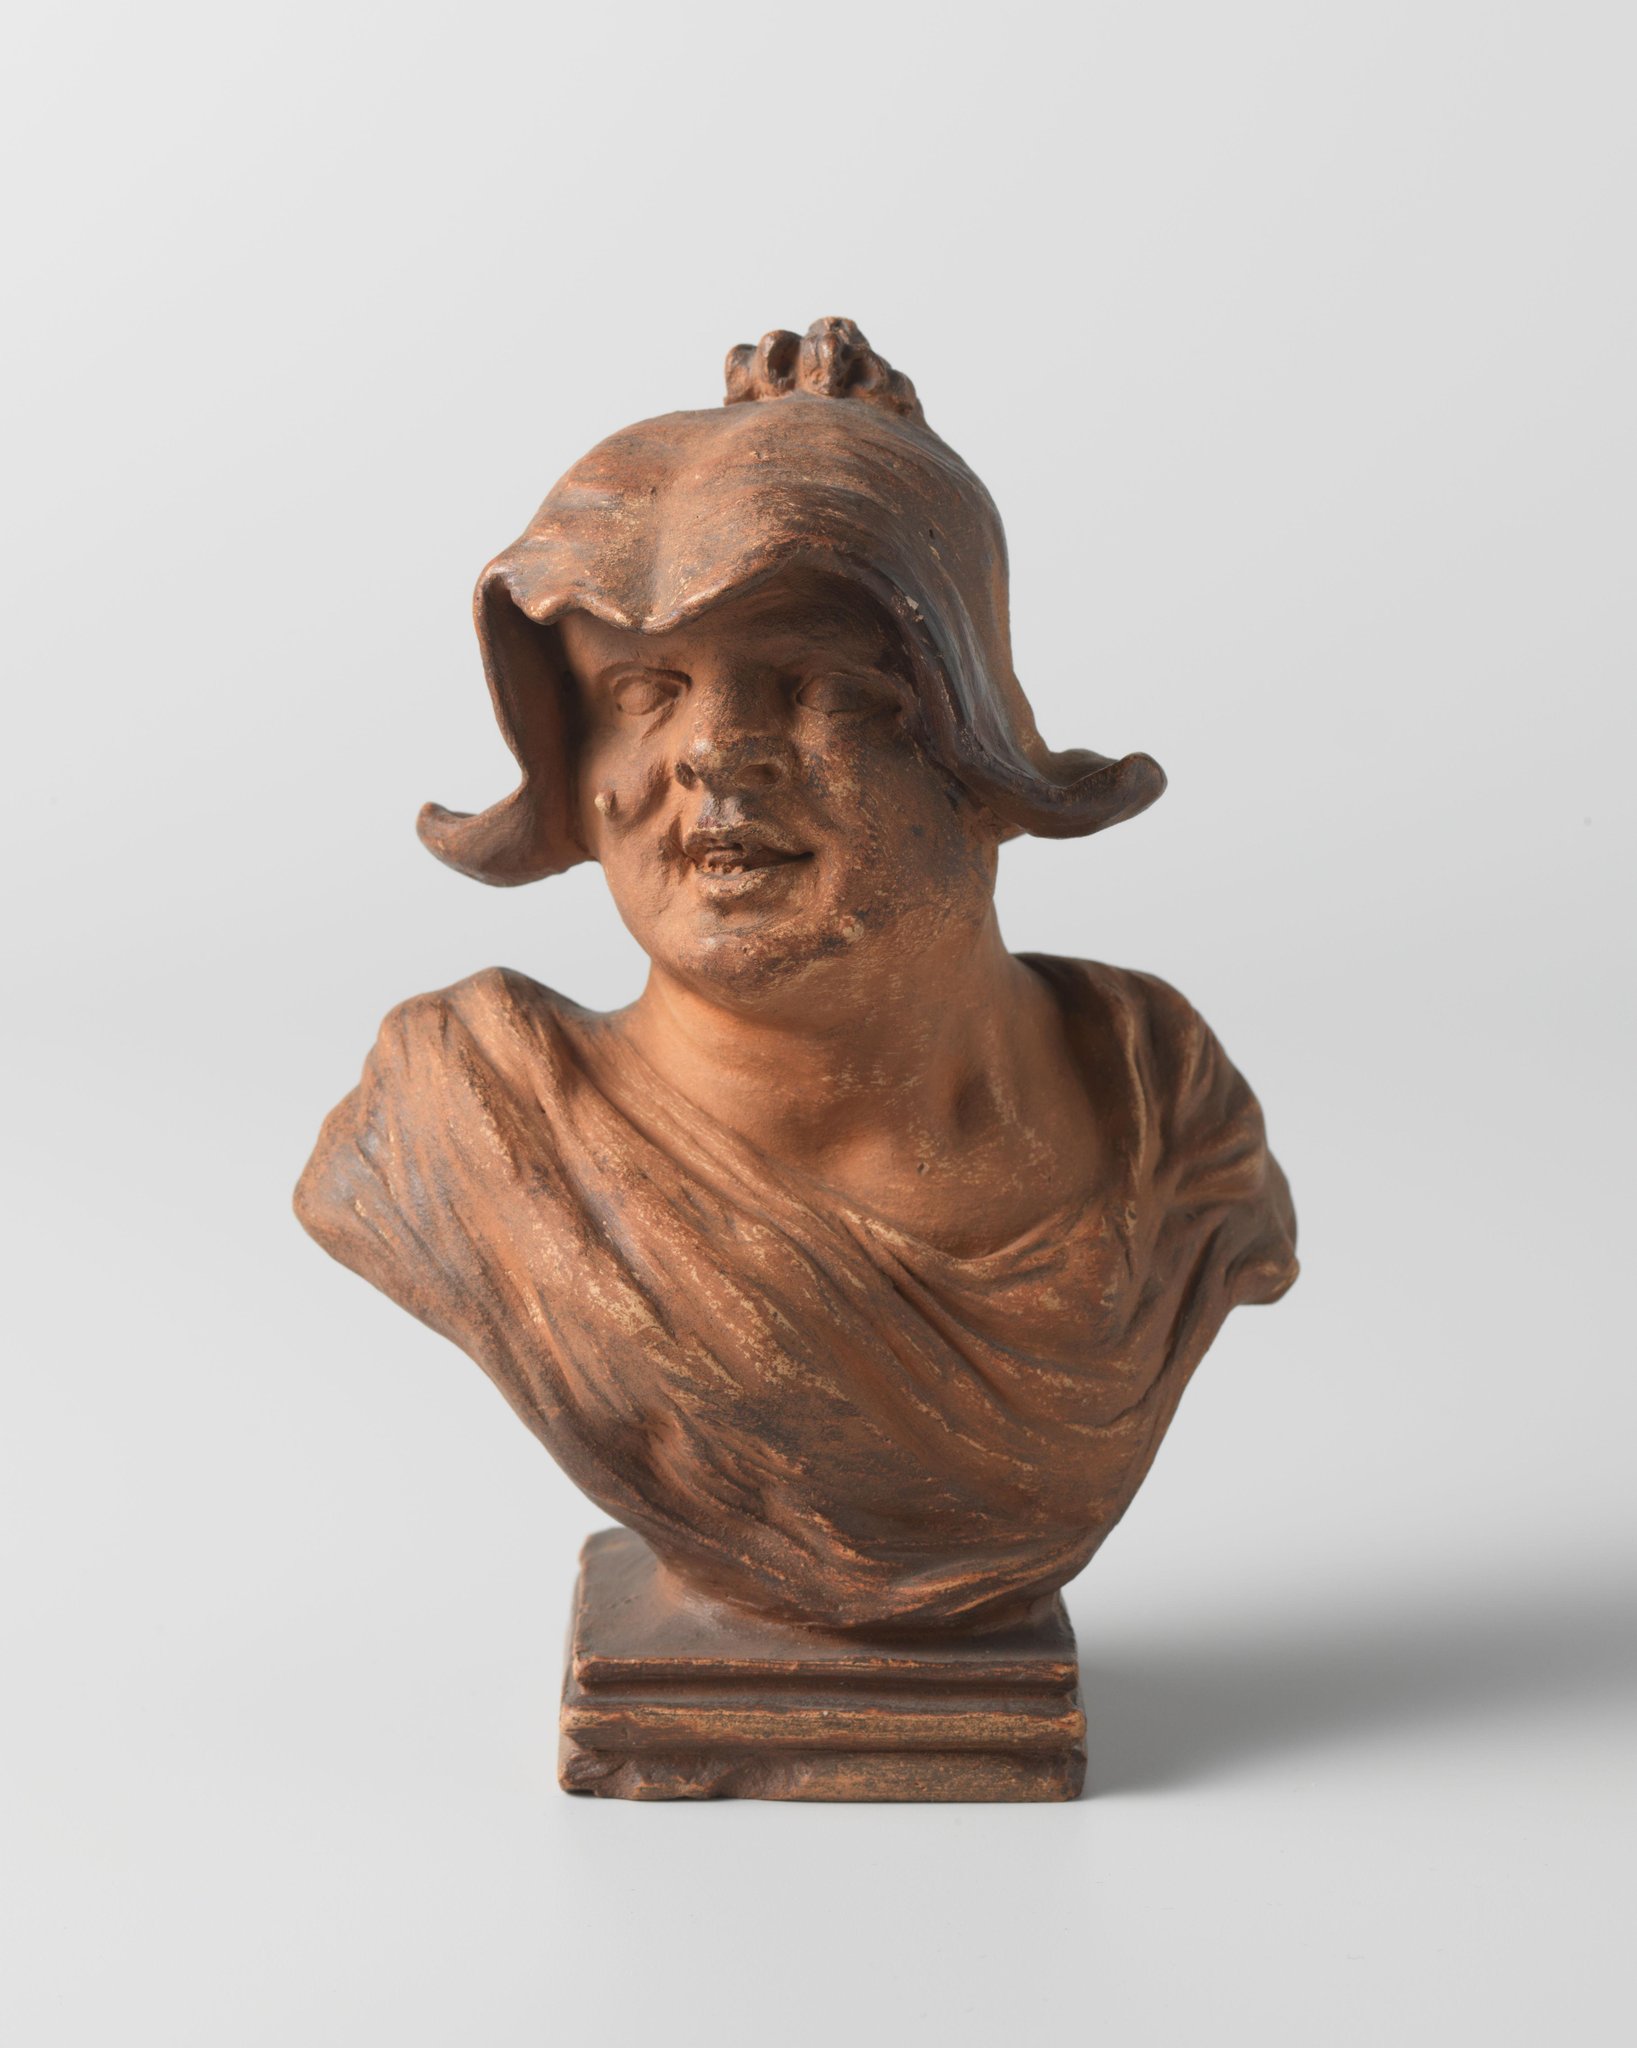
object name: sculpture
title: Bust of a Man in Women’s Attire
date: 1700-1800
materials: terracotta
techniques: modeling